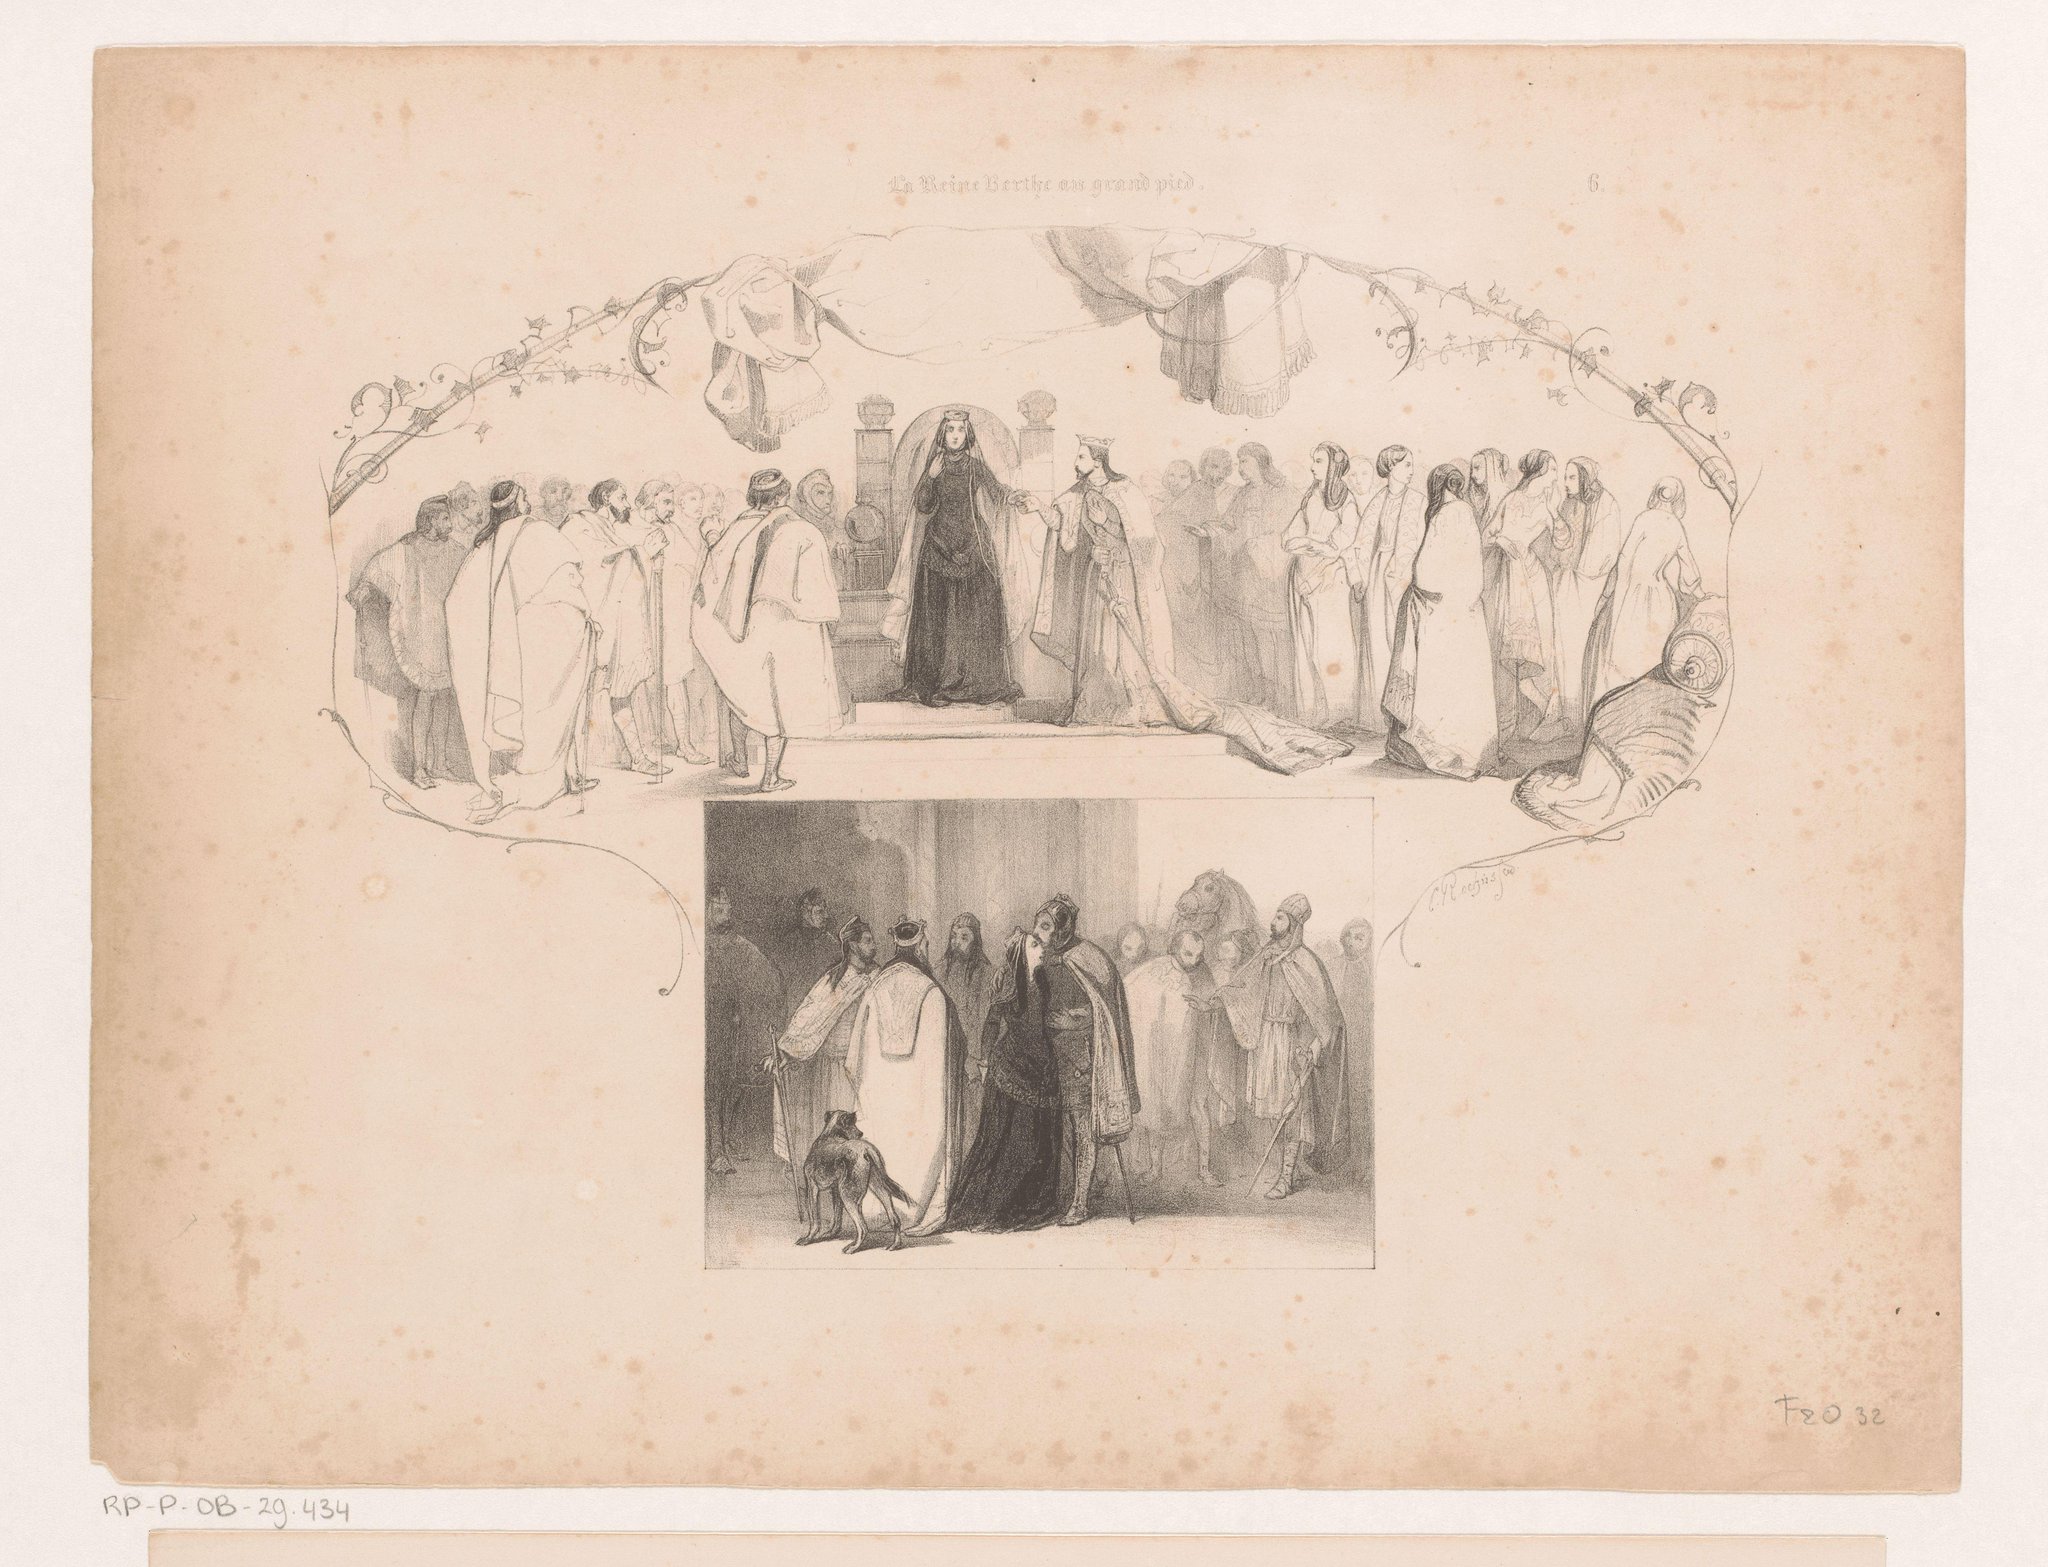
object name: print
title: Man kust koningin op het voorhoofd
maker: charles rochussen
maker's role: draughtsman, painter, print maker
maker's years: 1814-1894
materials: paper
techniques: lithograph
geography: the hague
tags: (lovers) kissing each other, queen, king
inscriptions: collector's mark: Lugt 2228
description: Een geharnaste man kust een koningin op het voorhoofd. Zij worden omringd door een groep mannen. Daarboven neemt een koning dezelfde koning bij de hand. Zij worden omgeven door mannen en vrouwen.